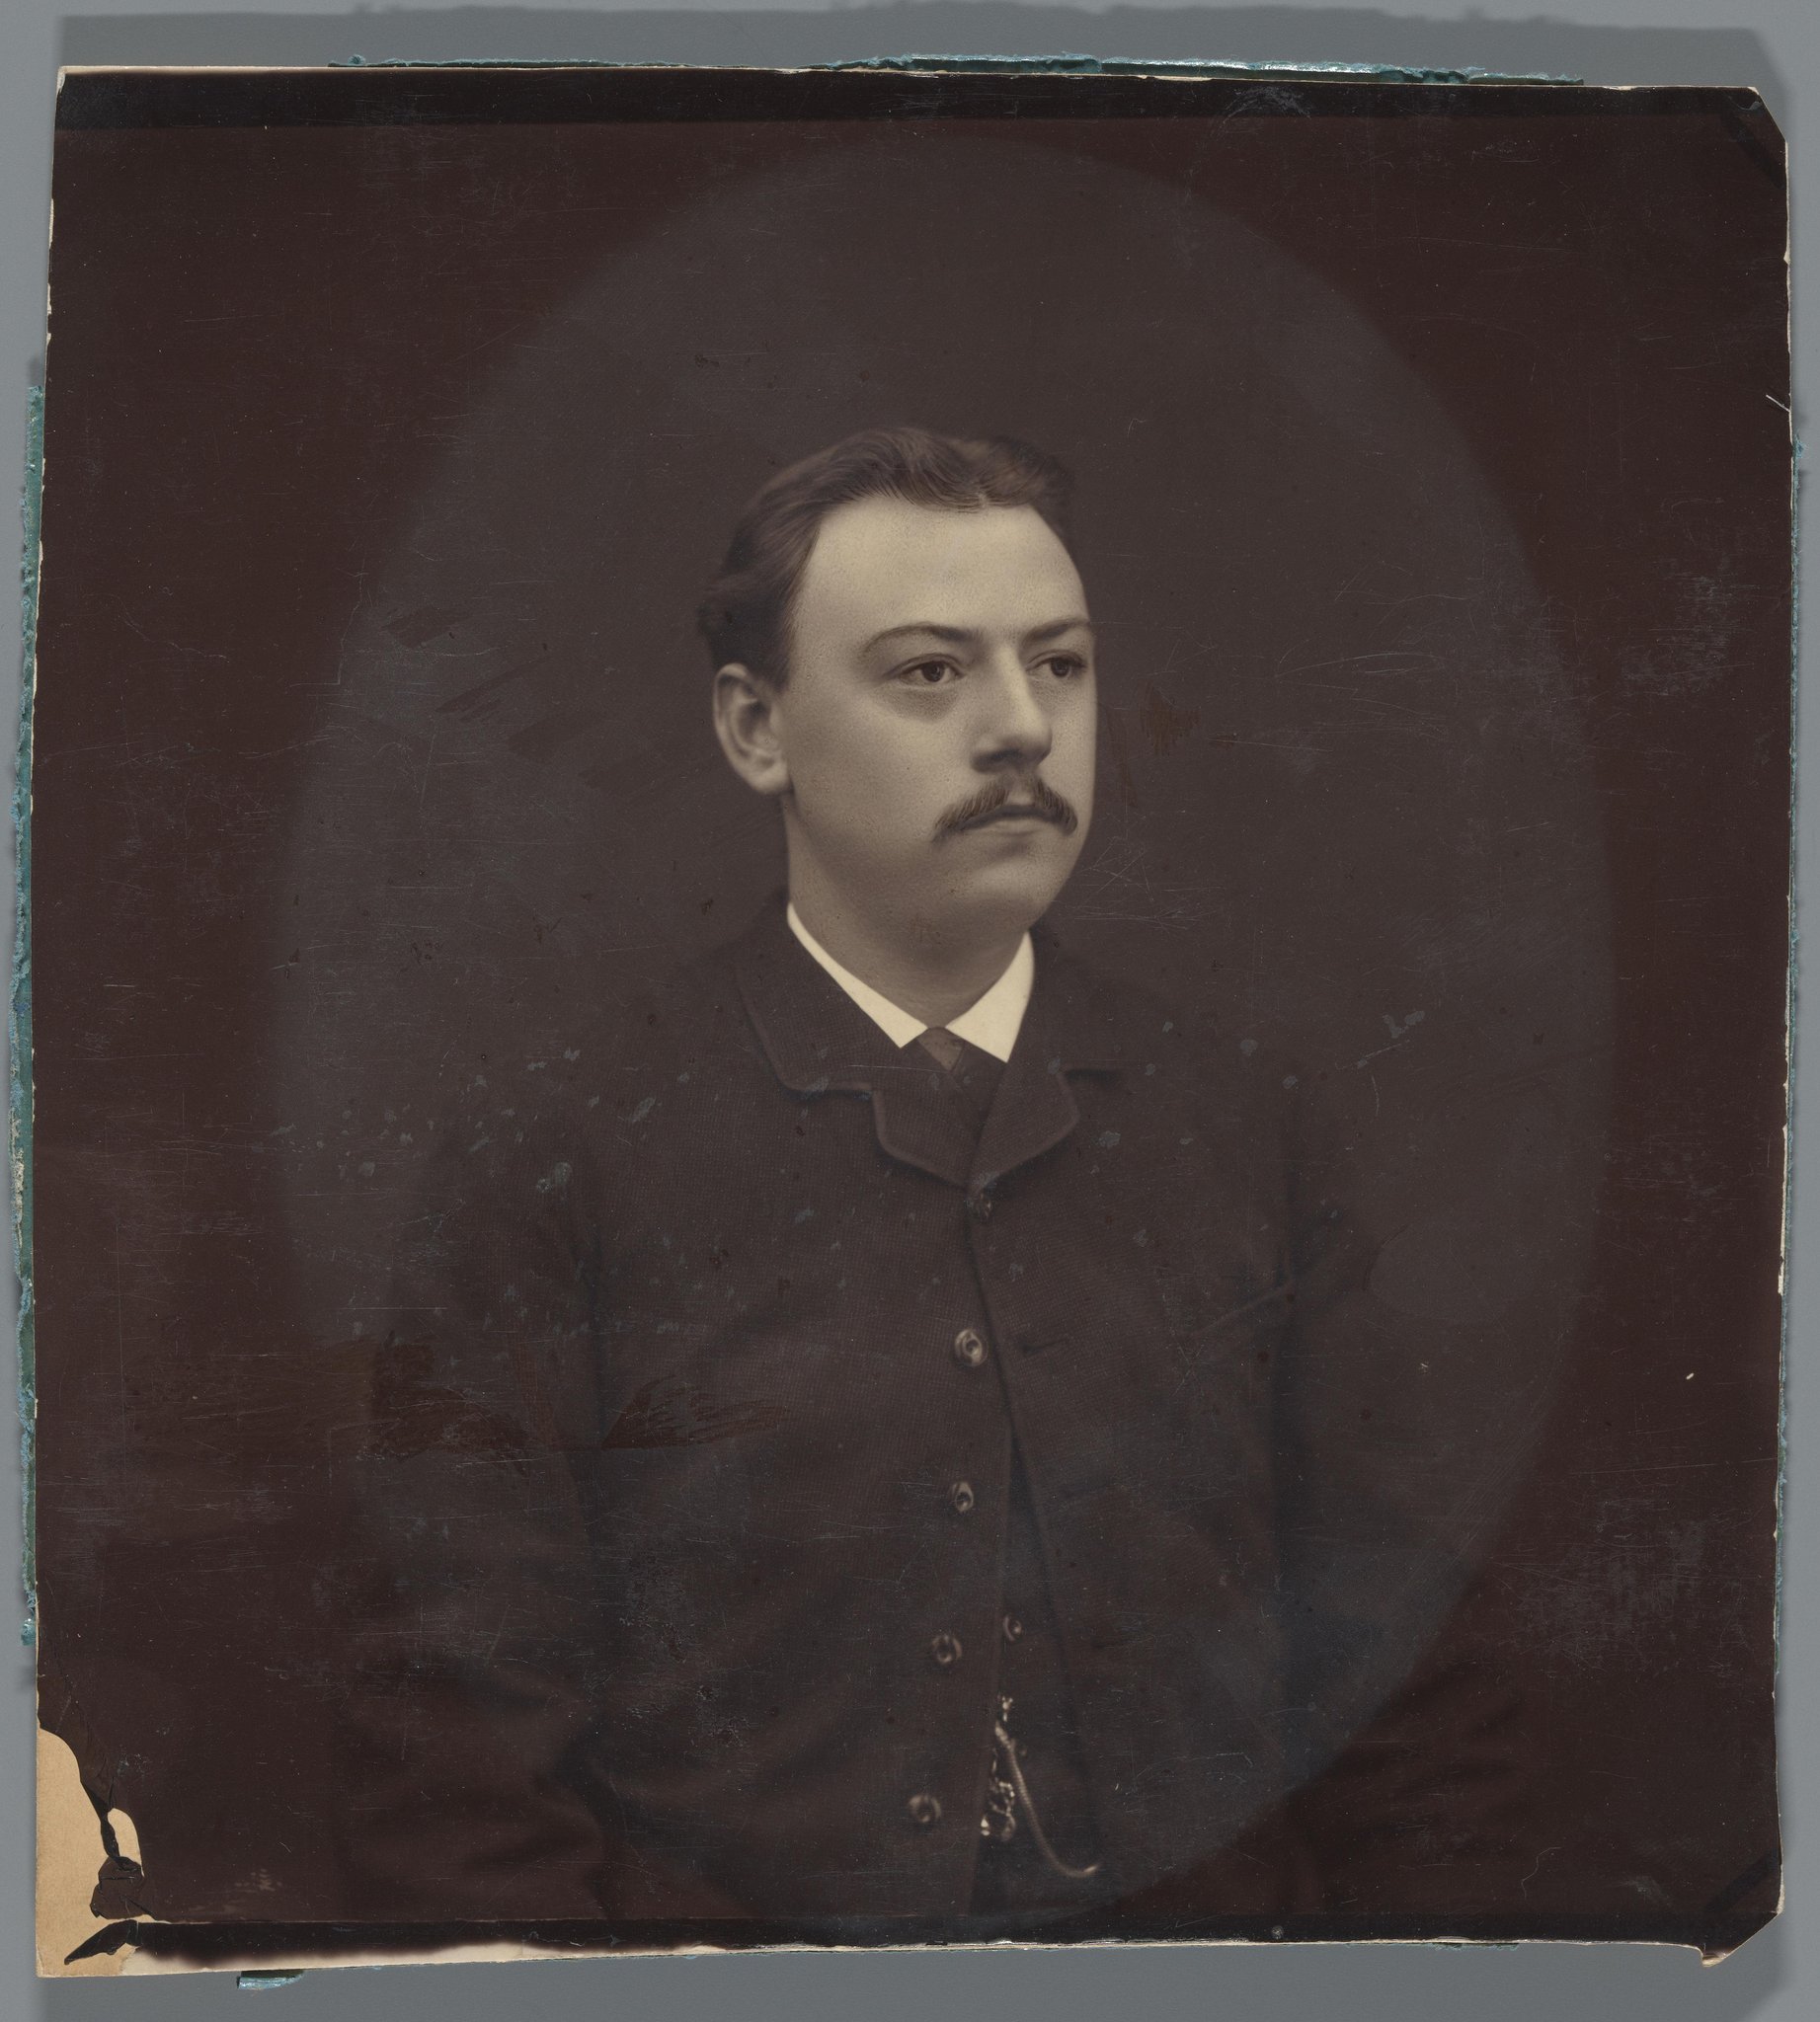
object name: photograph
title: Portret van een onbekende man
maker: Anonymous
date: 1880-1910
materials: paper, cardboard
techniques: gelatin silver print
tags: historical persons not known by name